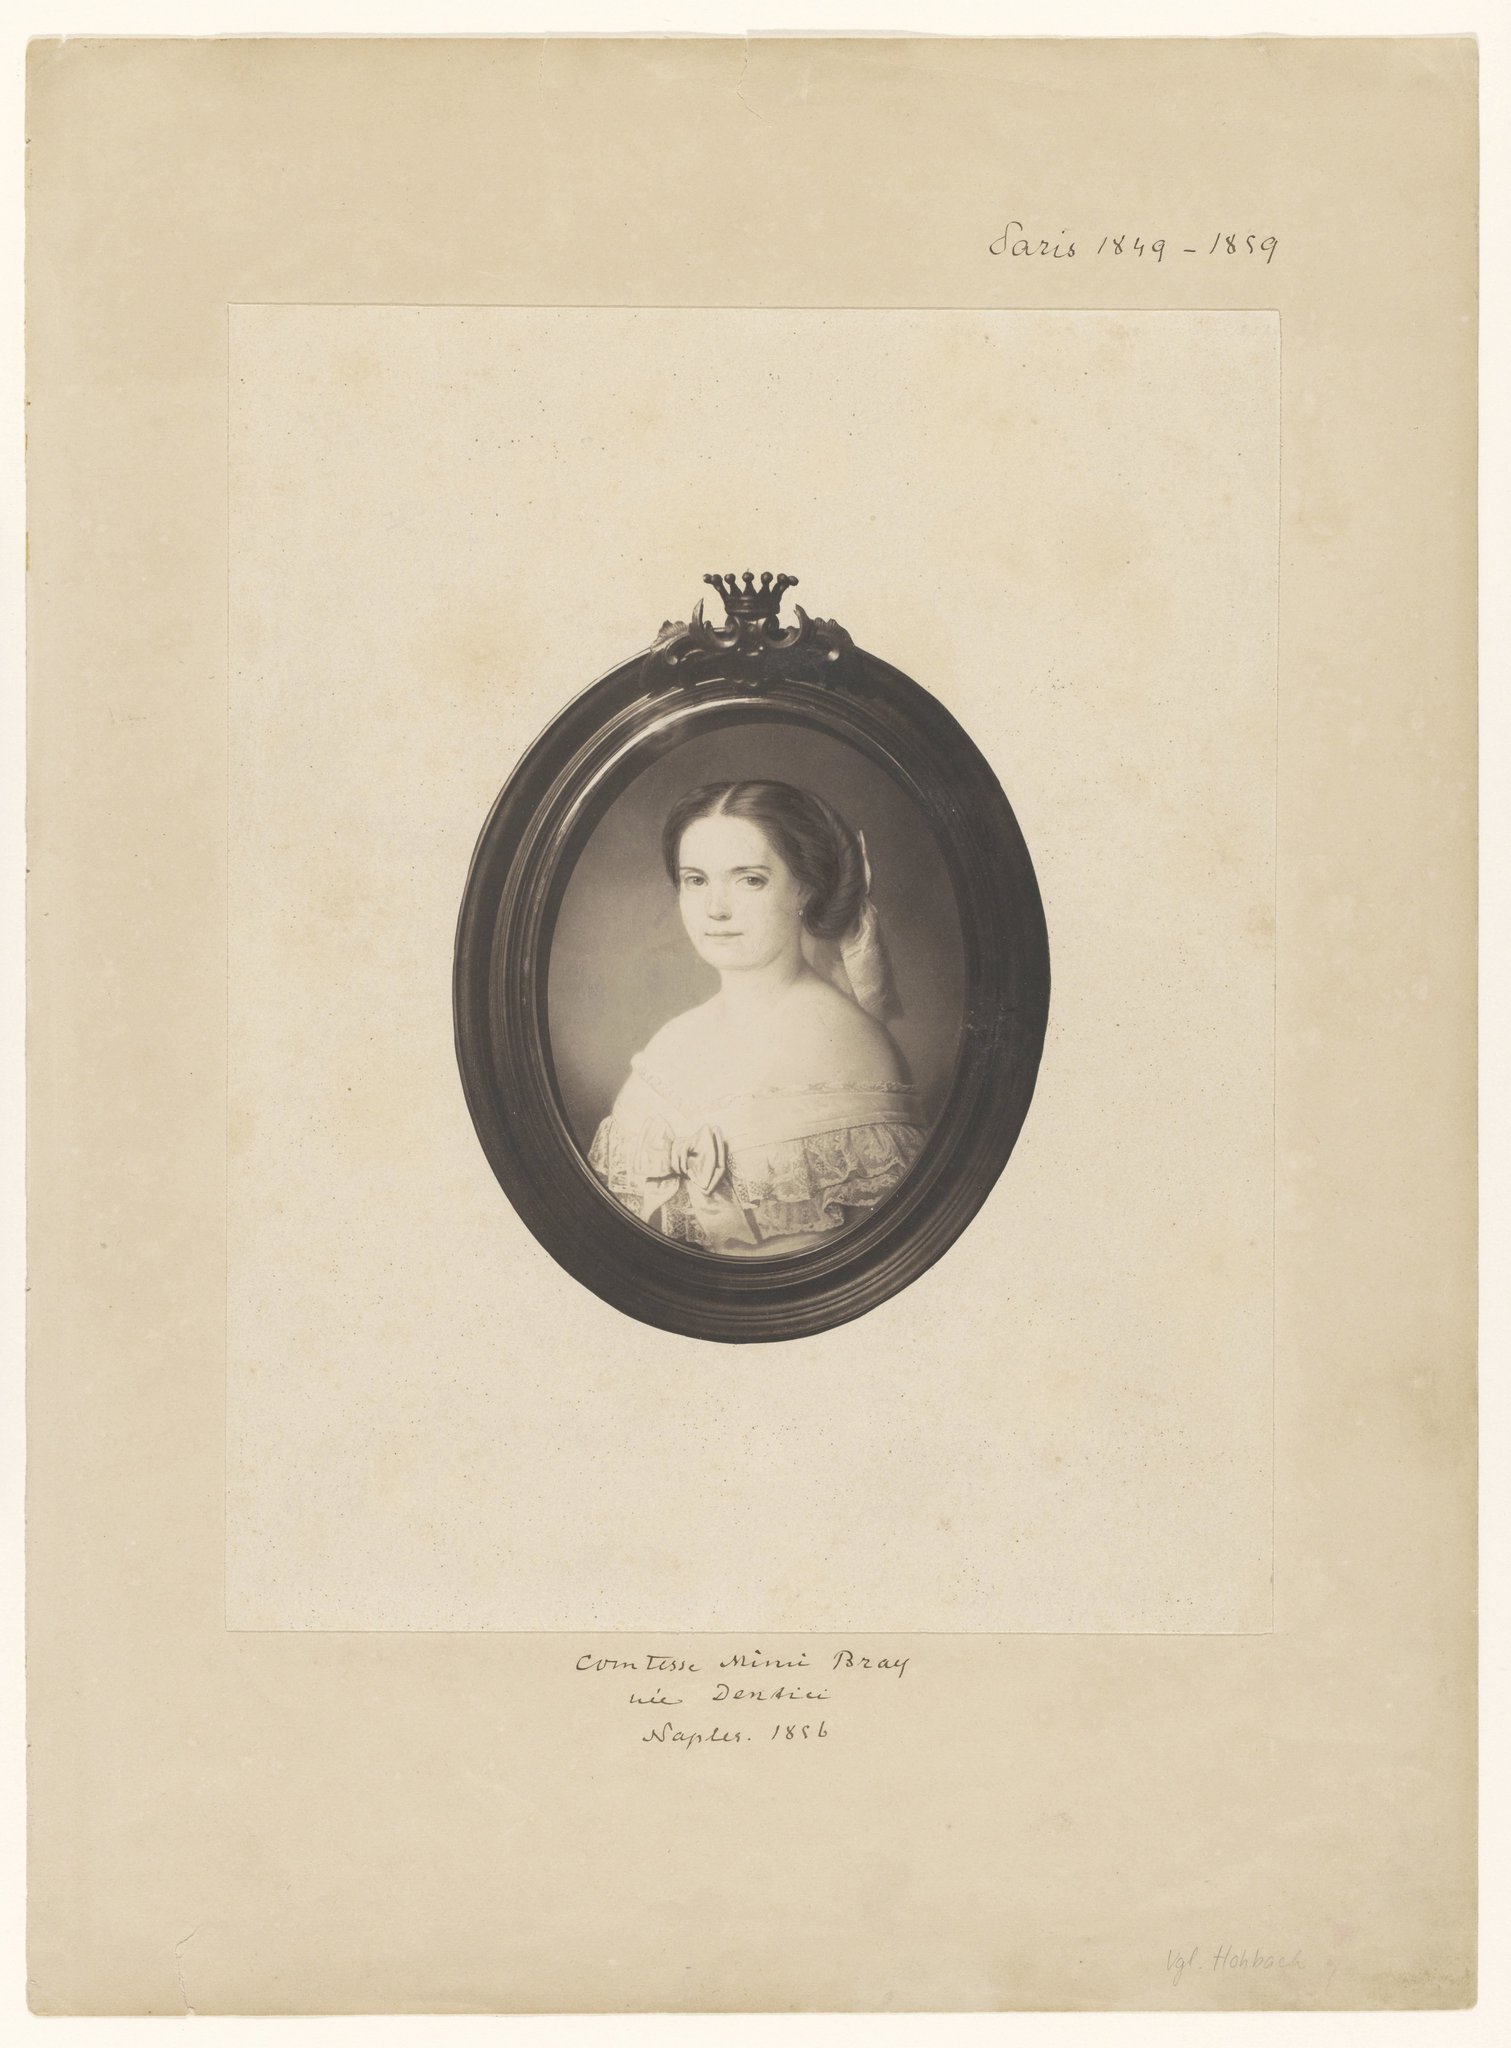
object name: reproduction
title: Fotoreproductie van een geschilderd portret van gravin Mimi Bray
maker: franz seraph hanfstaengl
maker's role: painter, print maker, printer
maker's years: 1804-1877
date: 1856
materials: cardboard, paper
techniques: salted paper print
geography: naples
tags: adult woman, historical persons, naples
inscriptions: inscription: ‘Vgl. Hohbach’, inscription: ‘Comtesse Mimi Bray/ née Dentici/ Naples, 1856’, inscription: ‘Paris 1849-1859’